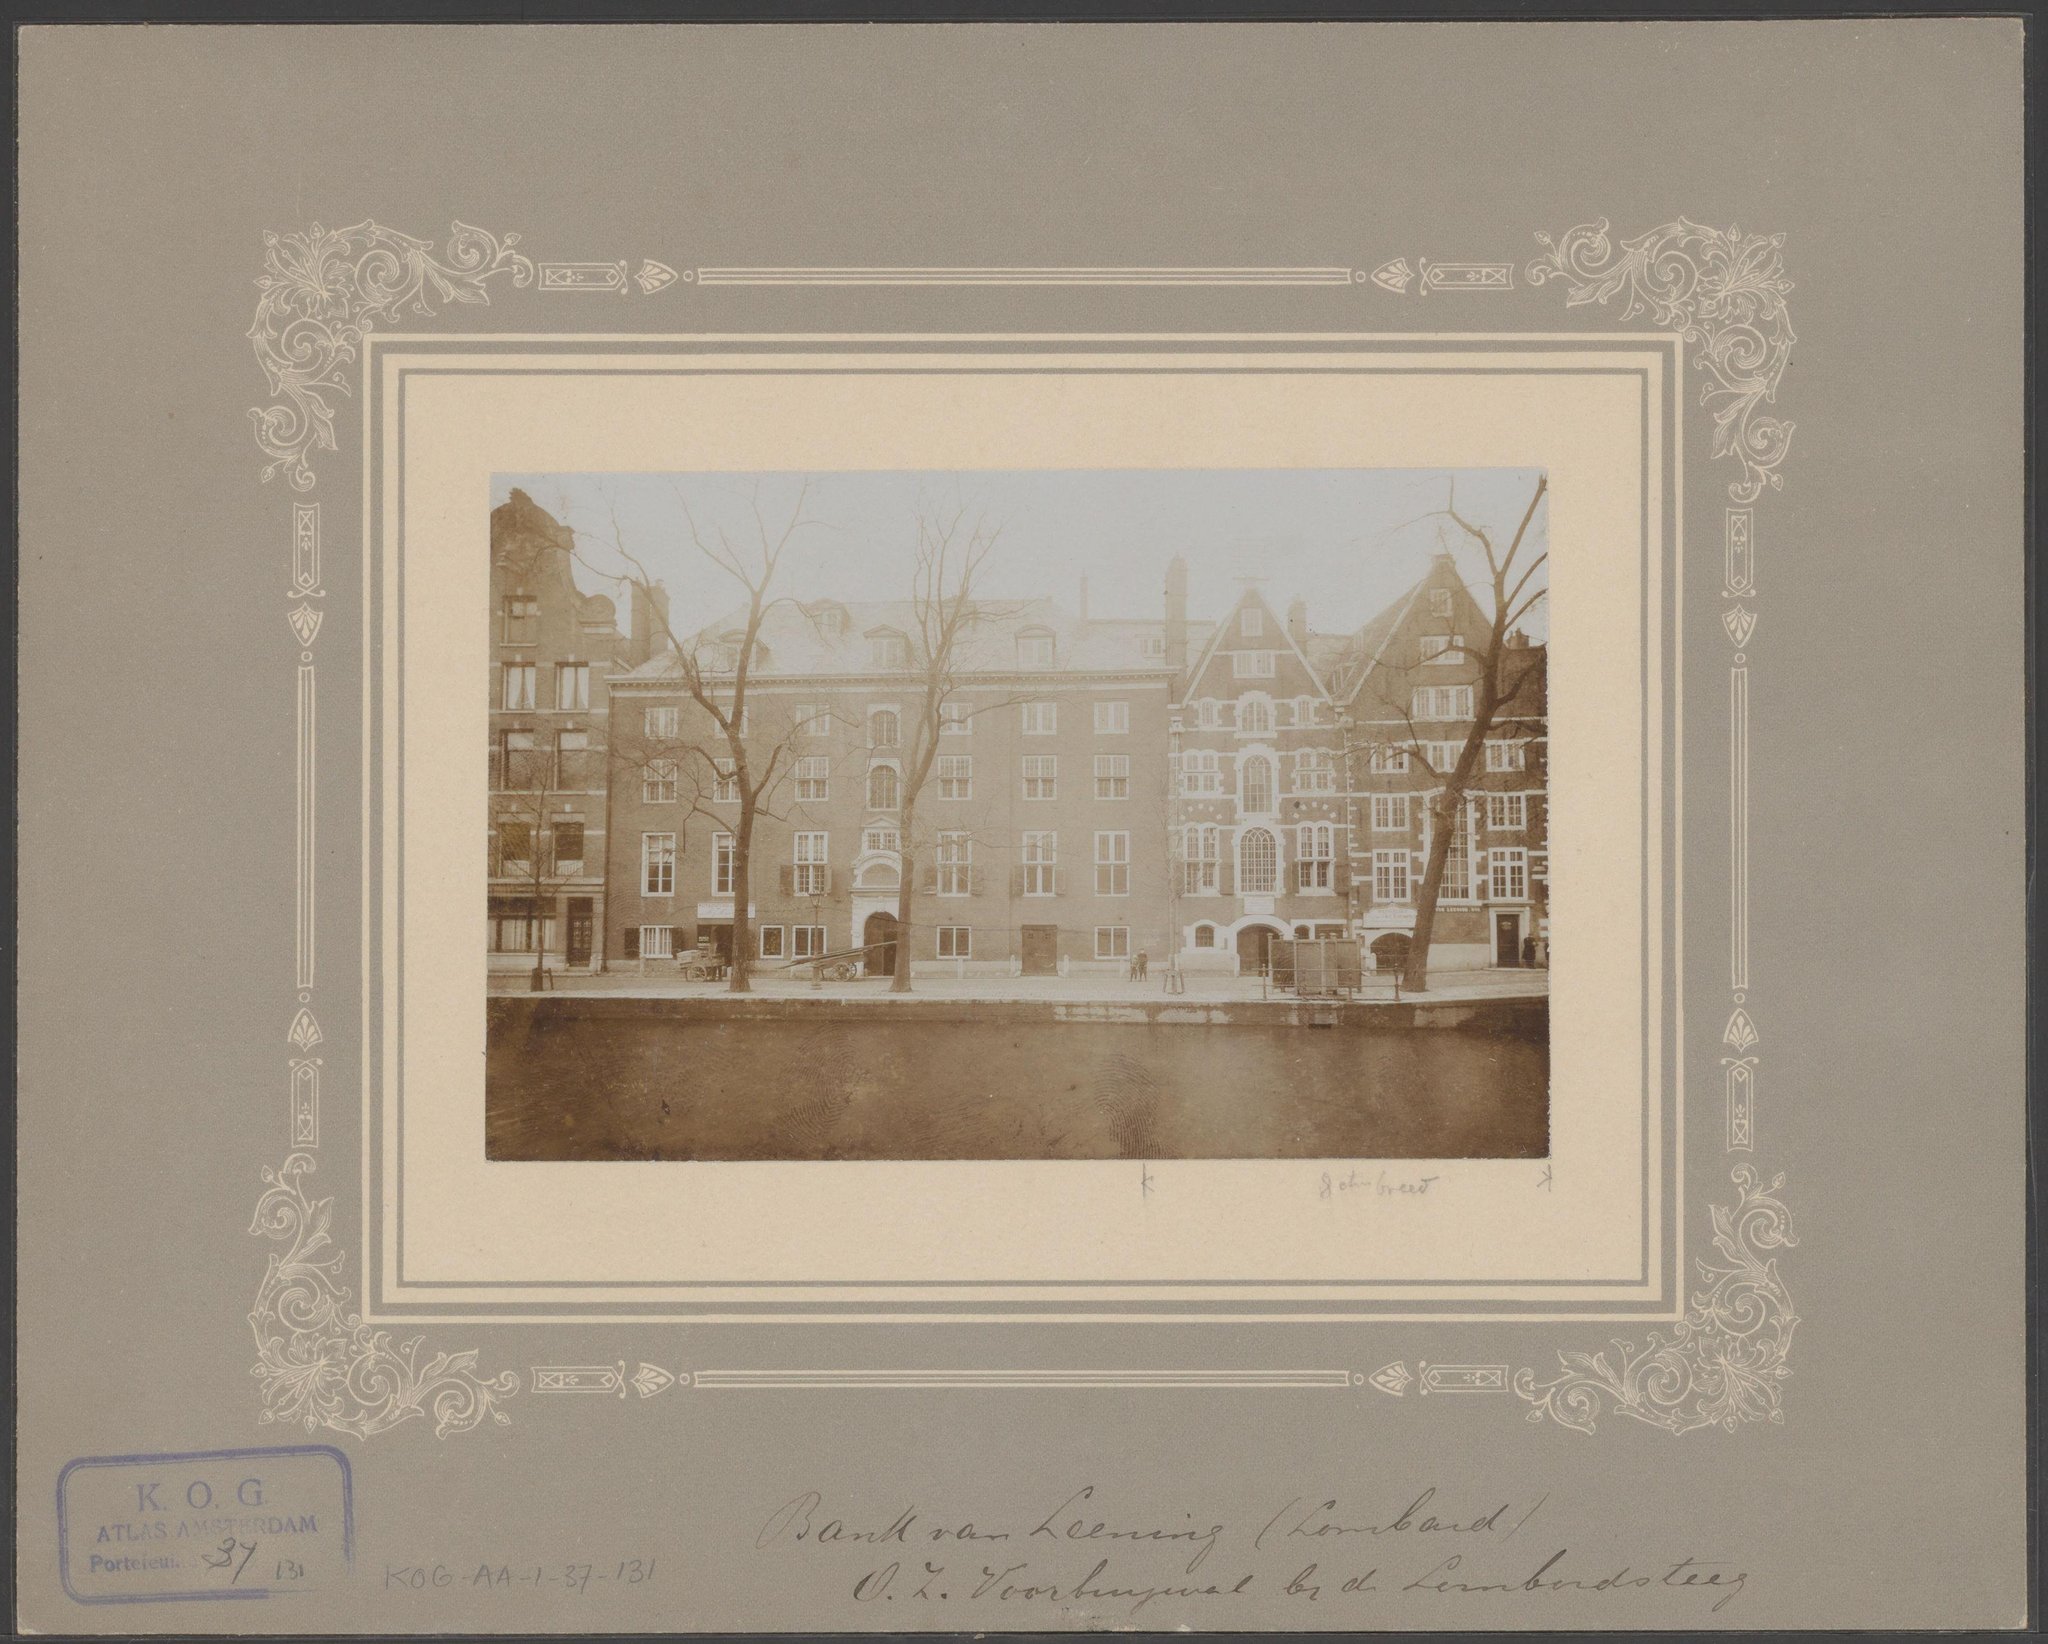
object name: photograph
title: Gezicht op de Stadsbank van Lening te Amsterdam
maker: Anonymous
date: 1880-1920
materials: paper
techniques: collodion silver print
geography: amsterdam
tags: pawnbroker, lombard, bank, canals, waters (in city) (+ city(-scape) with figures, staffage)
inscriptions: collector's mark: Lugt 1641b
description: Onderwerpsrubriek binnen de Atlas Amsterdam: Armwezen en liefdadige instellingen: I. Stadsinrichtingen: Lombard of Bank van Leening.